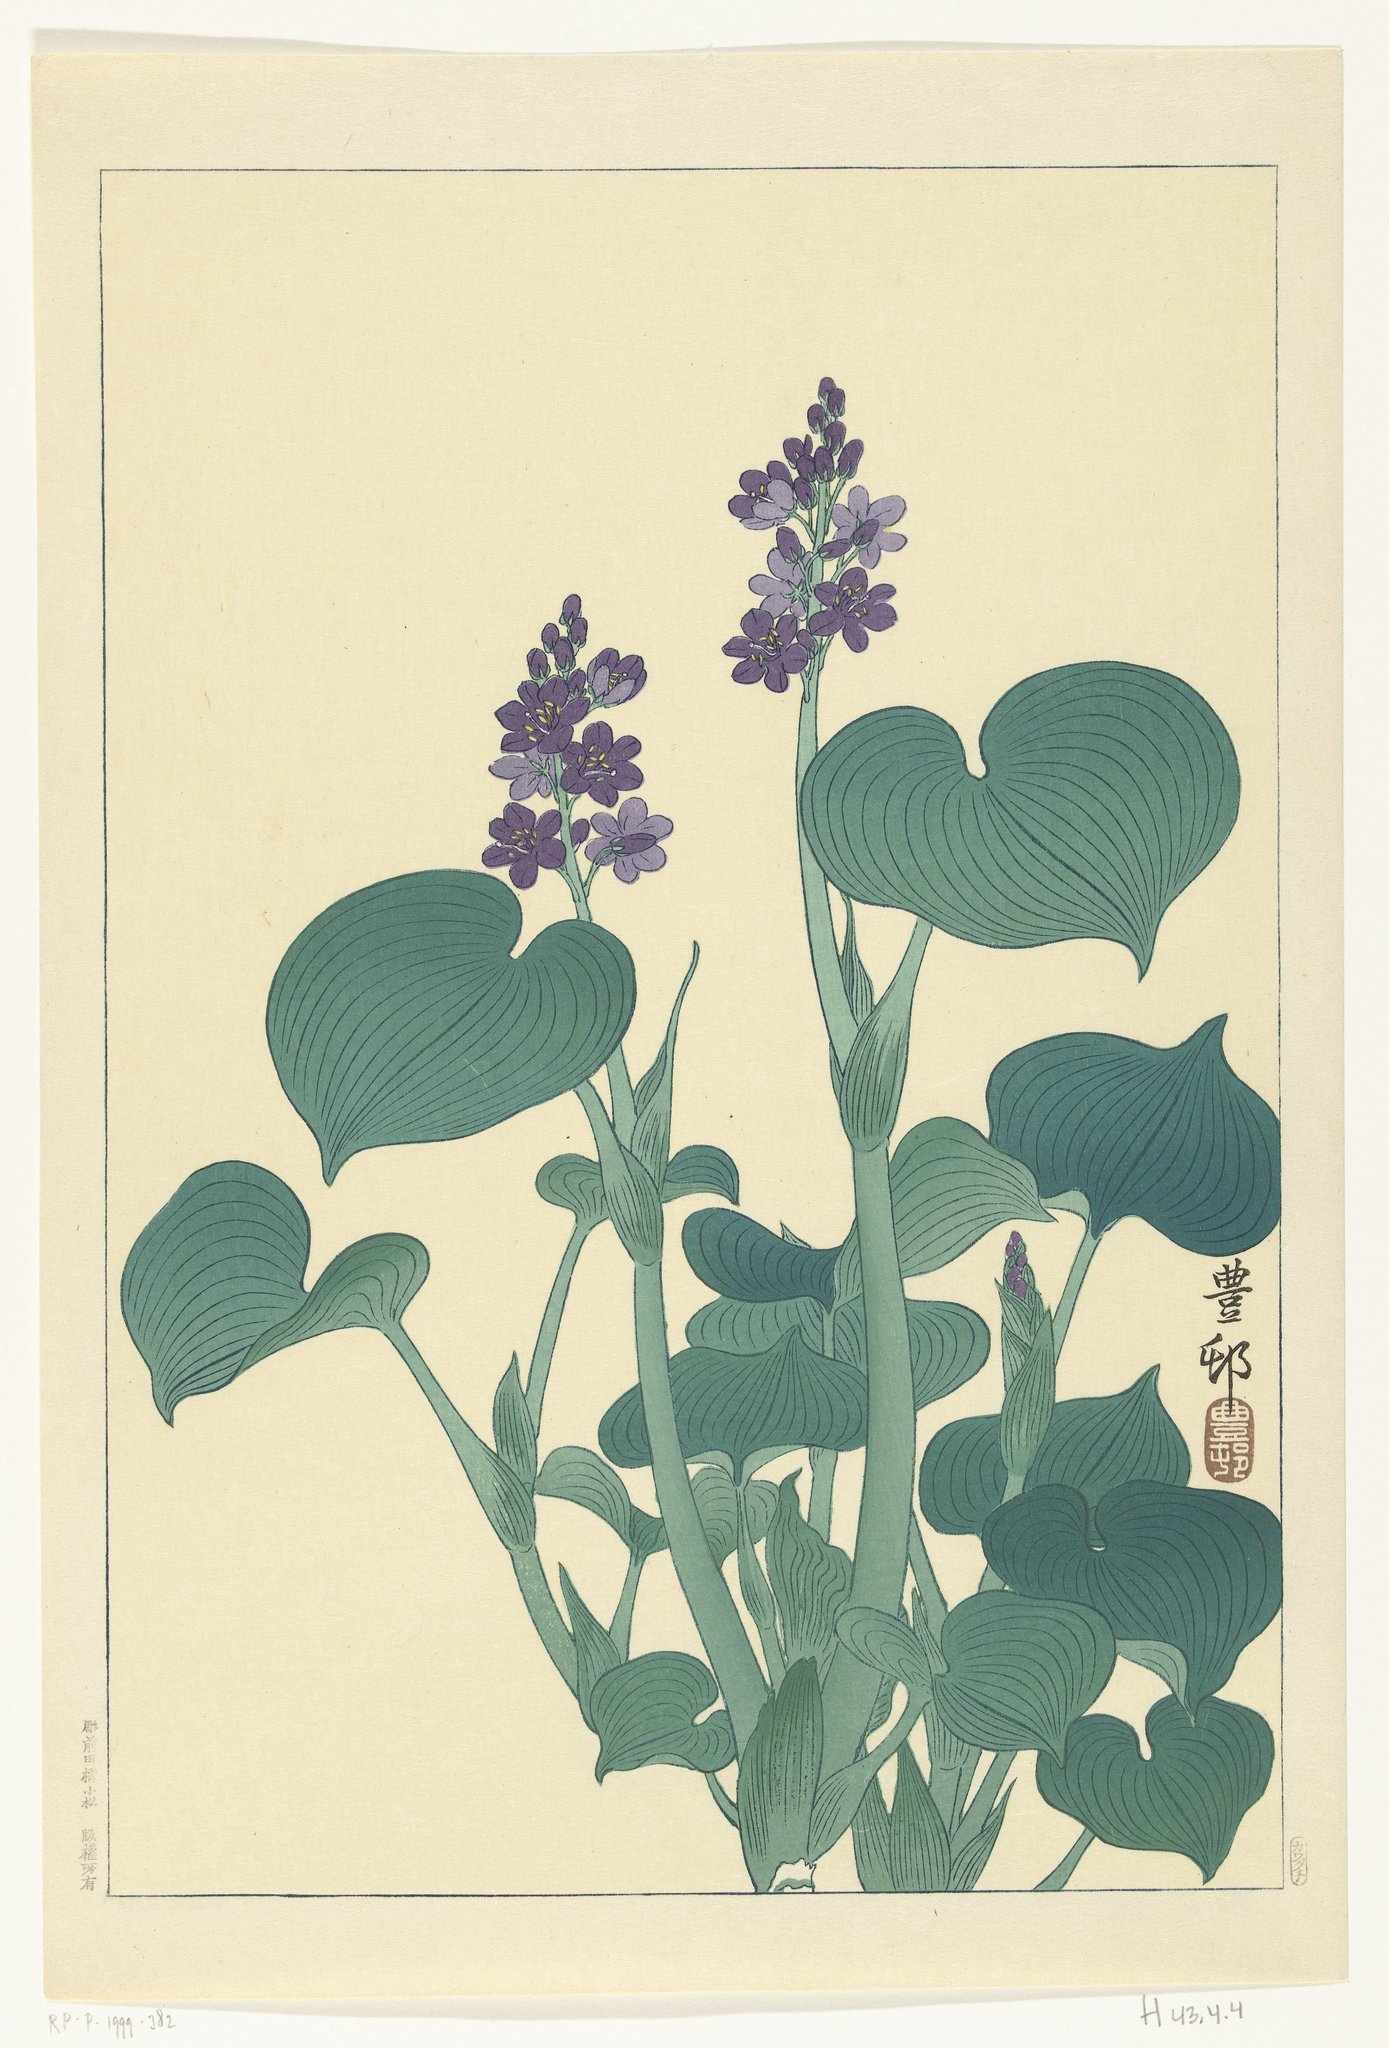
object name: print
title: Bloeiende hosta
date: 1920-1930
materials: paper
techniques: woodcut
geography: japan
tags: plants; vegetation (+ flowers, blossom, blossoming)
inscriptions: collector's mark: Lugt 2228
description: Bloeiende plant met kleine paarse bloemen en groot groen blad